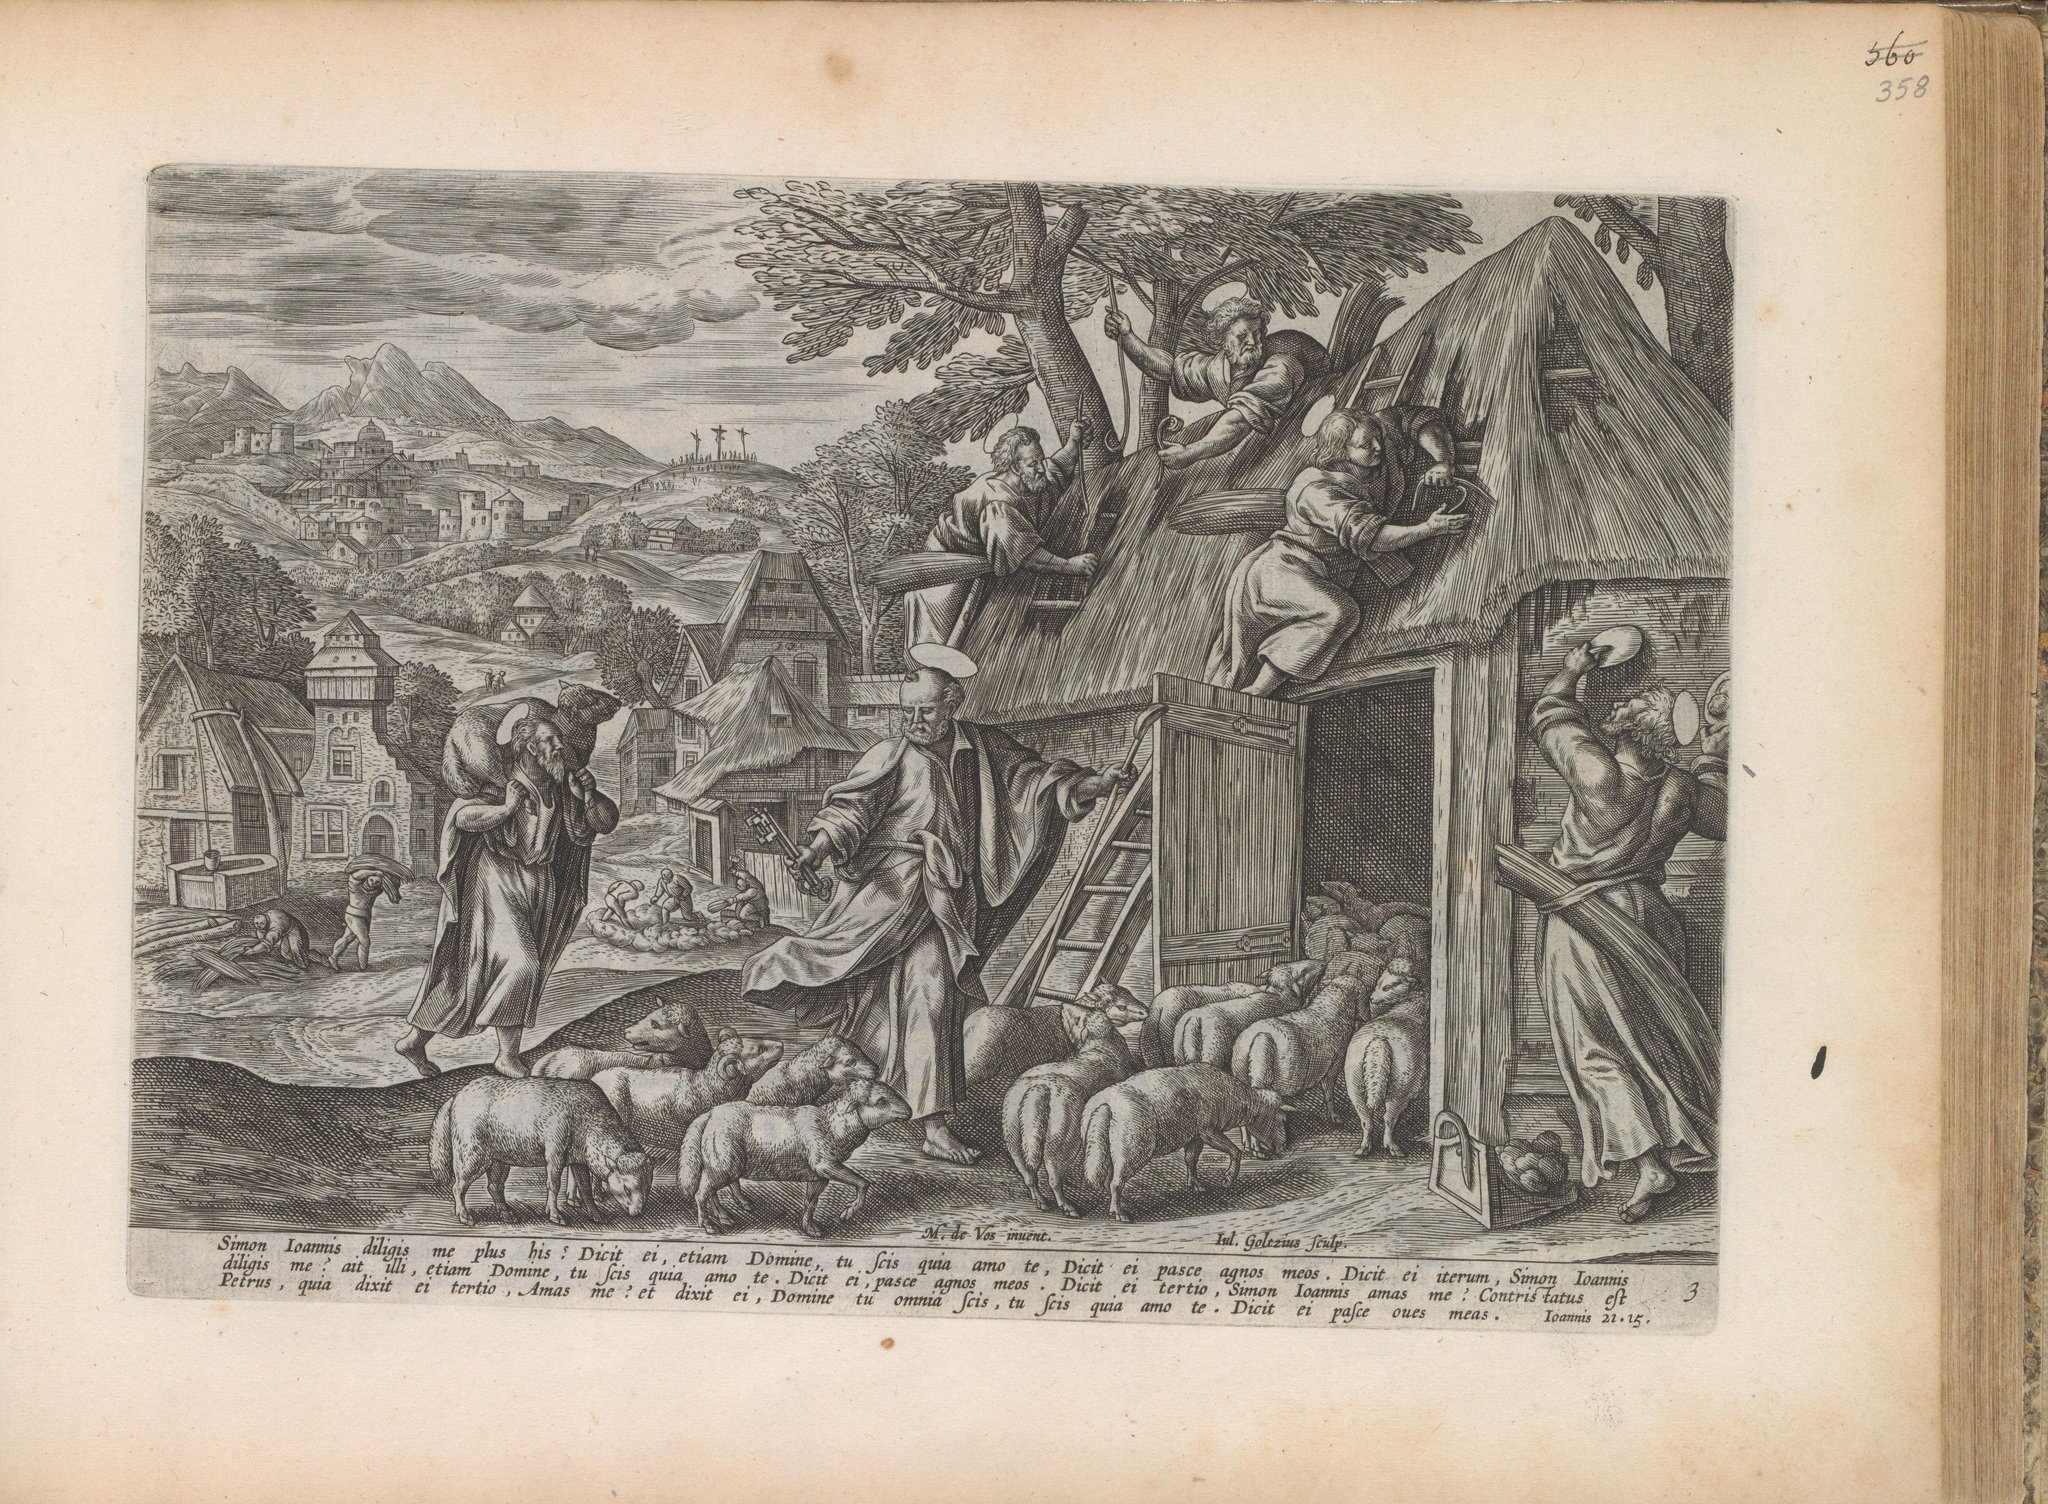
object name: print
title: Theatrum Biblicum Hoc Est Historiae Sacrae Veteris et Novi Testamenti Tabulis Aeneis Expressae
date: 1643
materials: paper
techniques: engraving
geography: amsterdam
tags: mission of peter ('pasce oves meas'): christ pointing to a lamb, peter perhaps with keys in his hands (+ variant), the good shepherd (christ) defending his sheep against wolves; 'i am the good shepherd' (john 10:1-16), other groups of apostles, the apostle peter, first bishop of rome; possible attributes: book, cock, (upturned) cross, (triple) crozier, fish, key, scroll, ship, tiara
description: De apostel Petrus als goede herder. Hij leidt zijn kudde schapen in een stal die door de andere apostelen in gereedheid wordt gebracht. Op de achtergrond een dorp. Aan de horizon Christus aan het kruis. Onder de voorstelling een verwijzing in het Latijn naar de Bijbeltekst in Joh. 21:15. Deze prent maakt deel uit van een album.